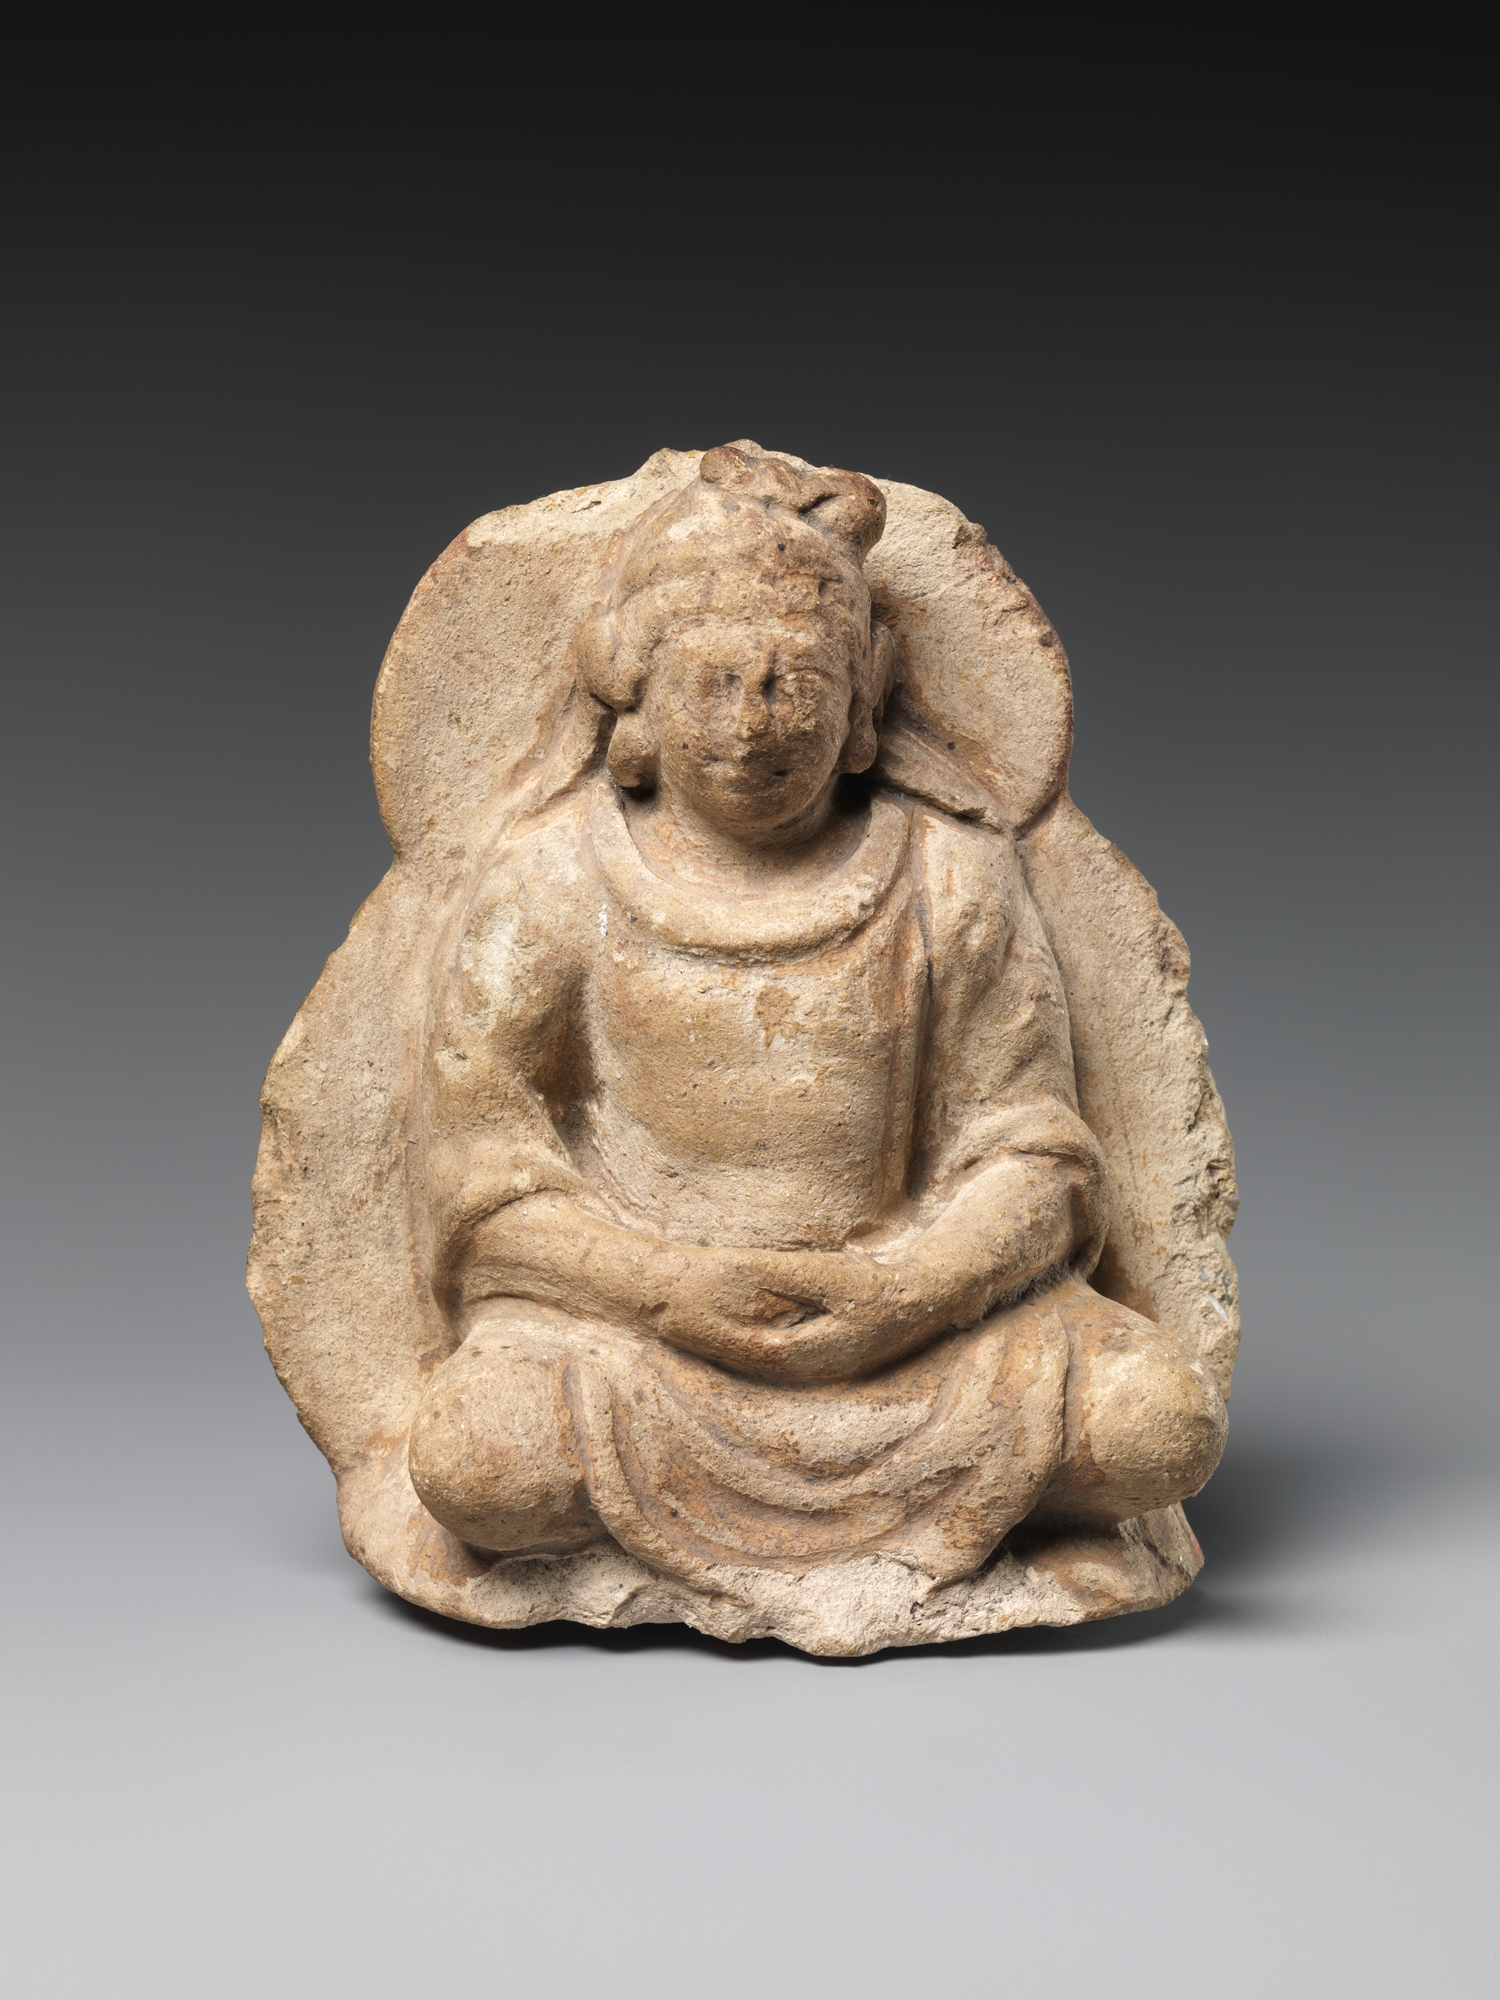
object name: statuette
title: Seated Bodhisattva with Combined Halo and Mandorla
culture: gandhara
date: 401-600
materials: plaster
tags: gandhara,buddhism,bodhisattvas